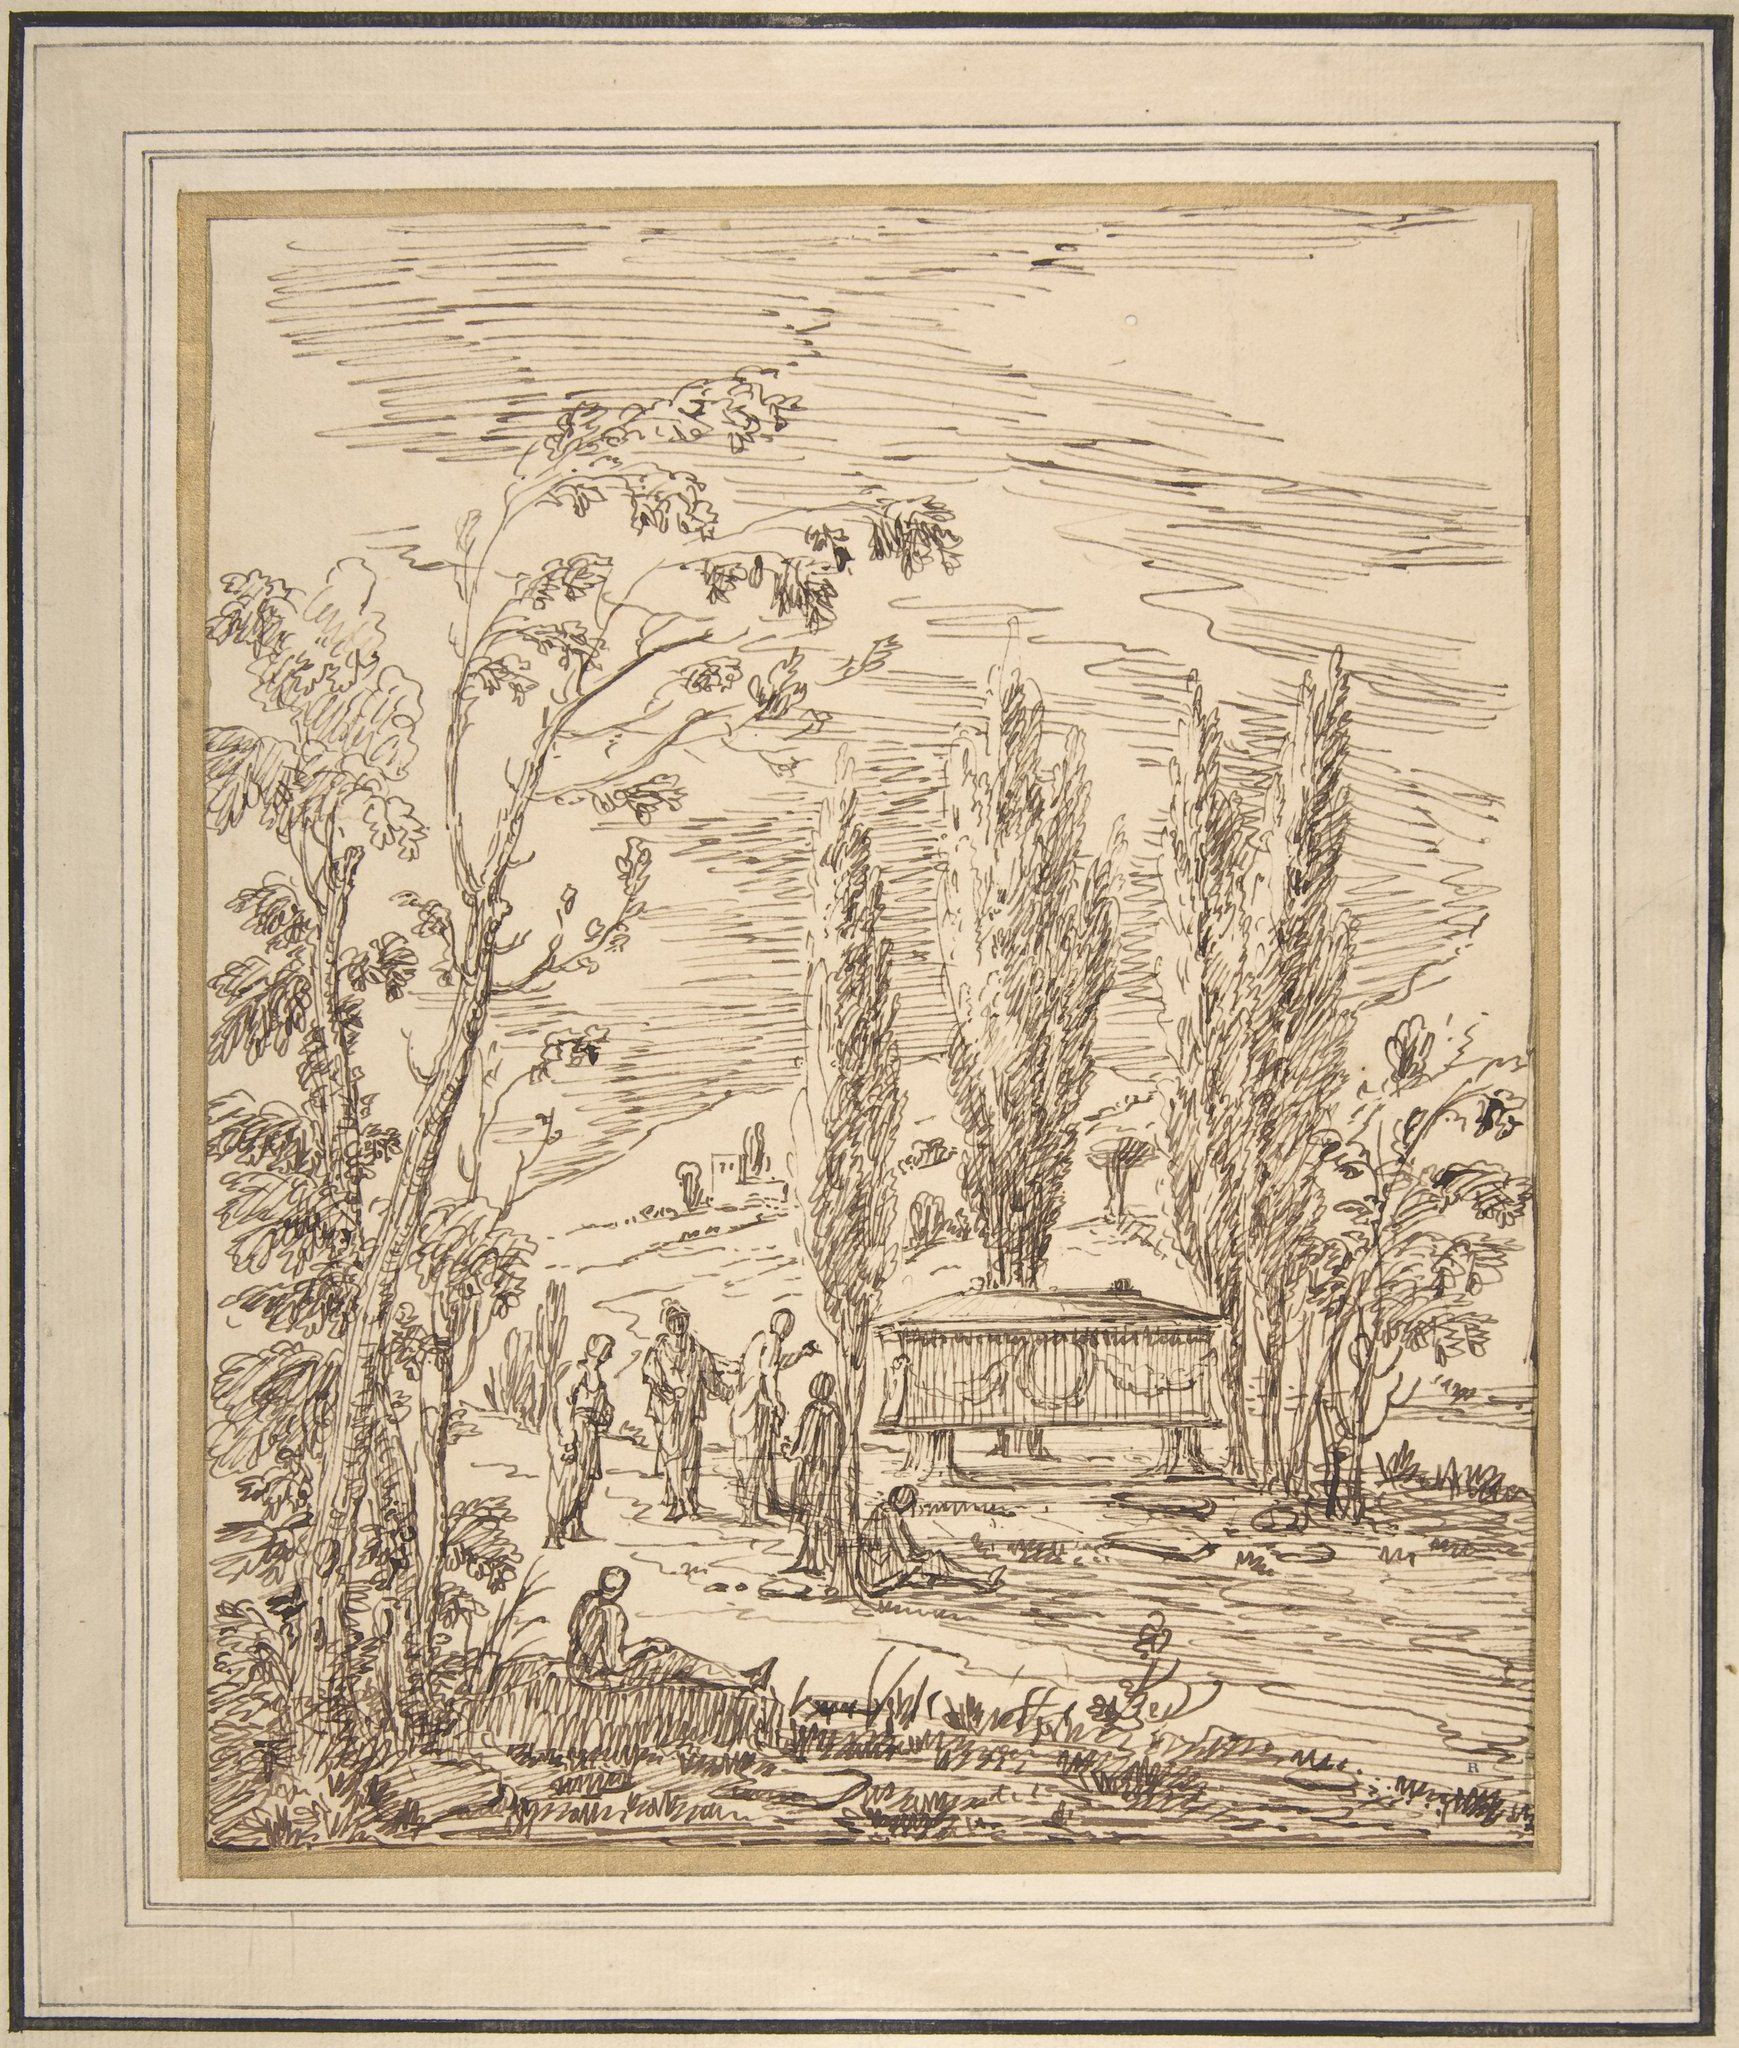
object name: drawing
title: Landscape with Figures near a Tomb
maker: gian antonio burrini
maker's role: artist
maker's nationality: italian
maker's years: 1656-1727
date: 1656-1727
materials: ink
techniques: pen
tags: human figures,tombs,landscapes,trees